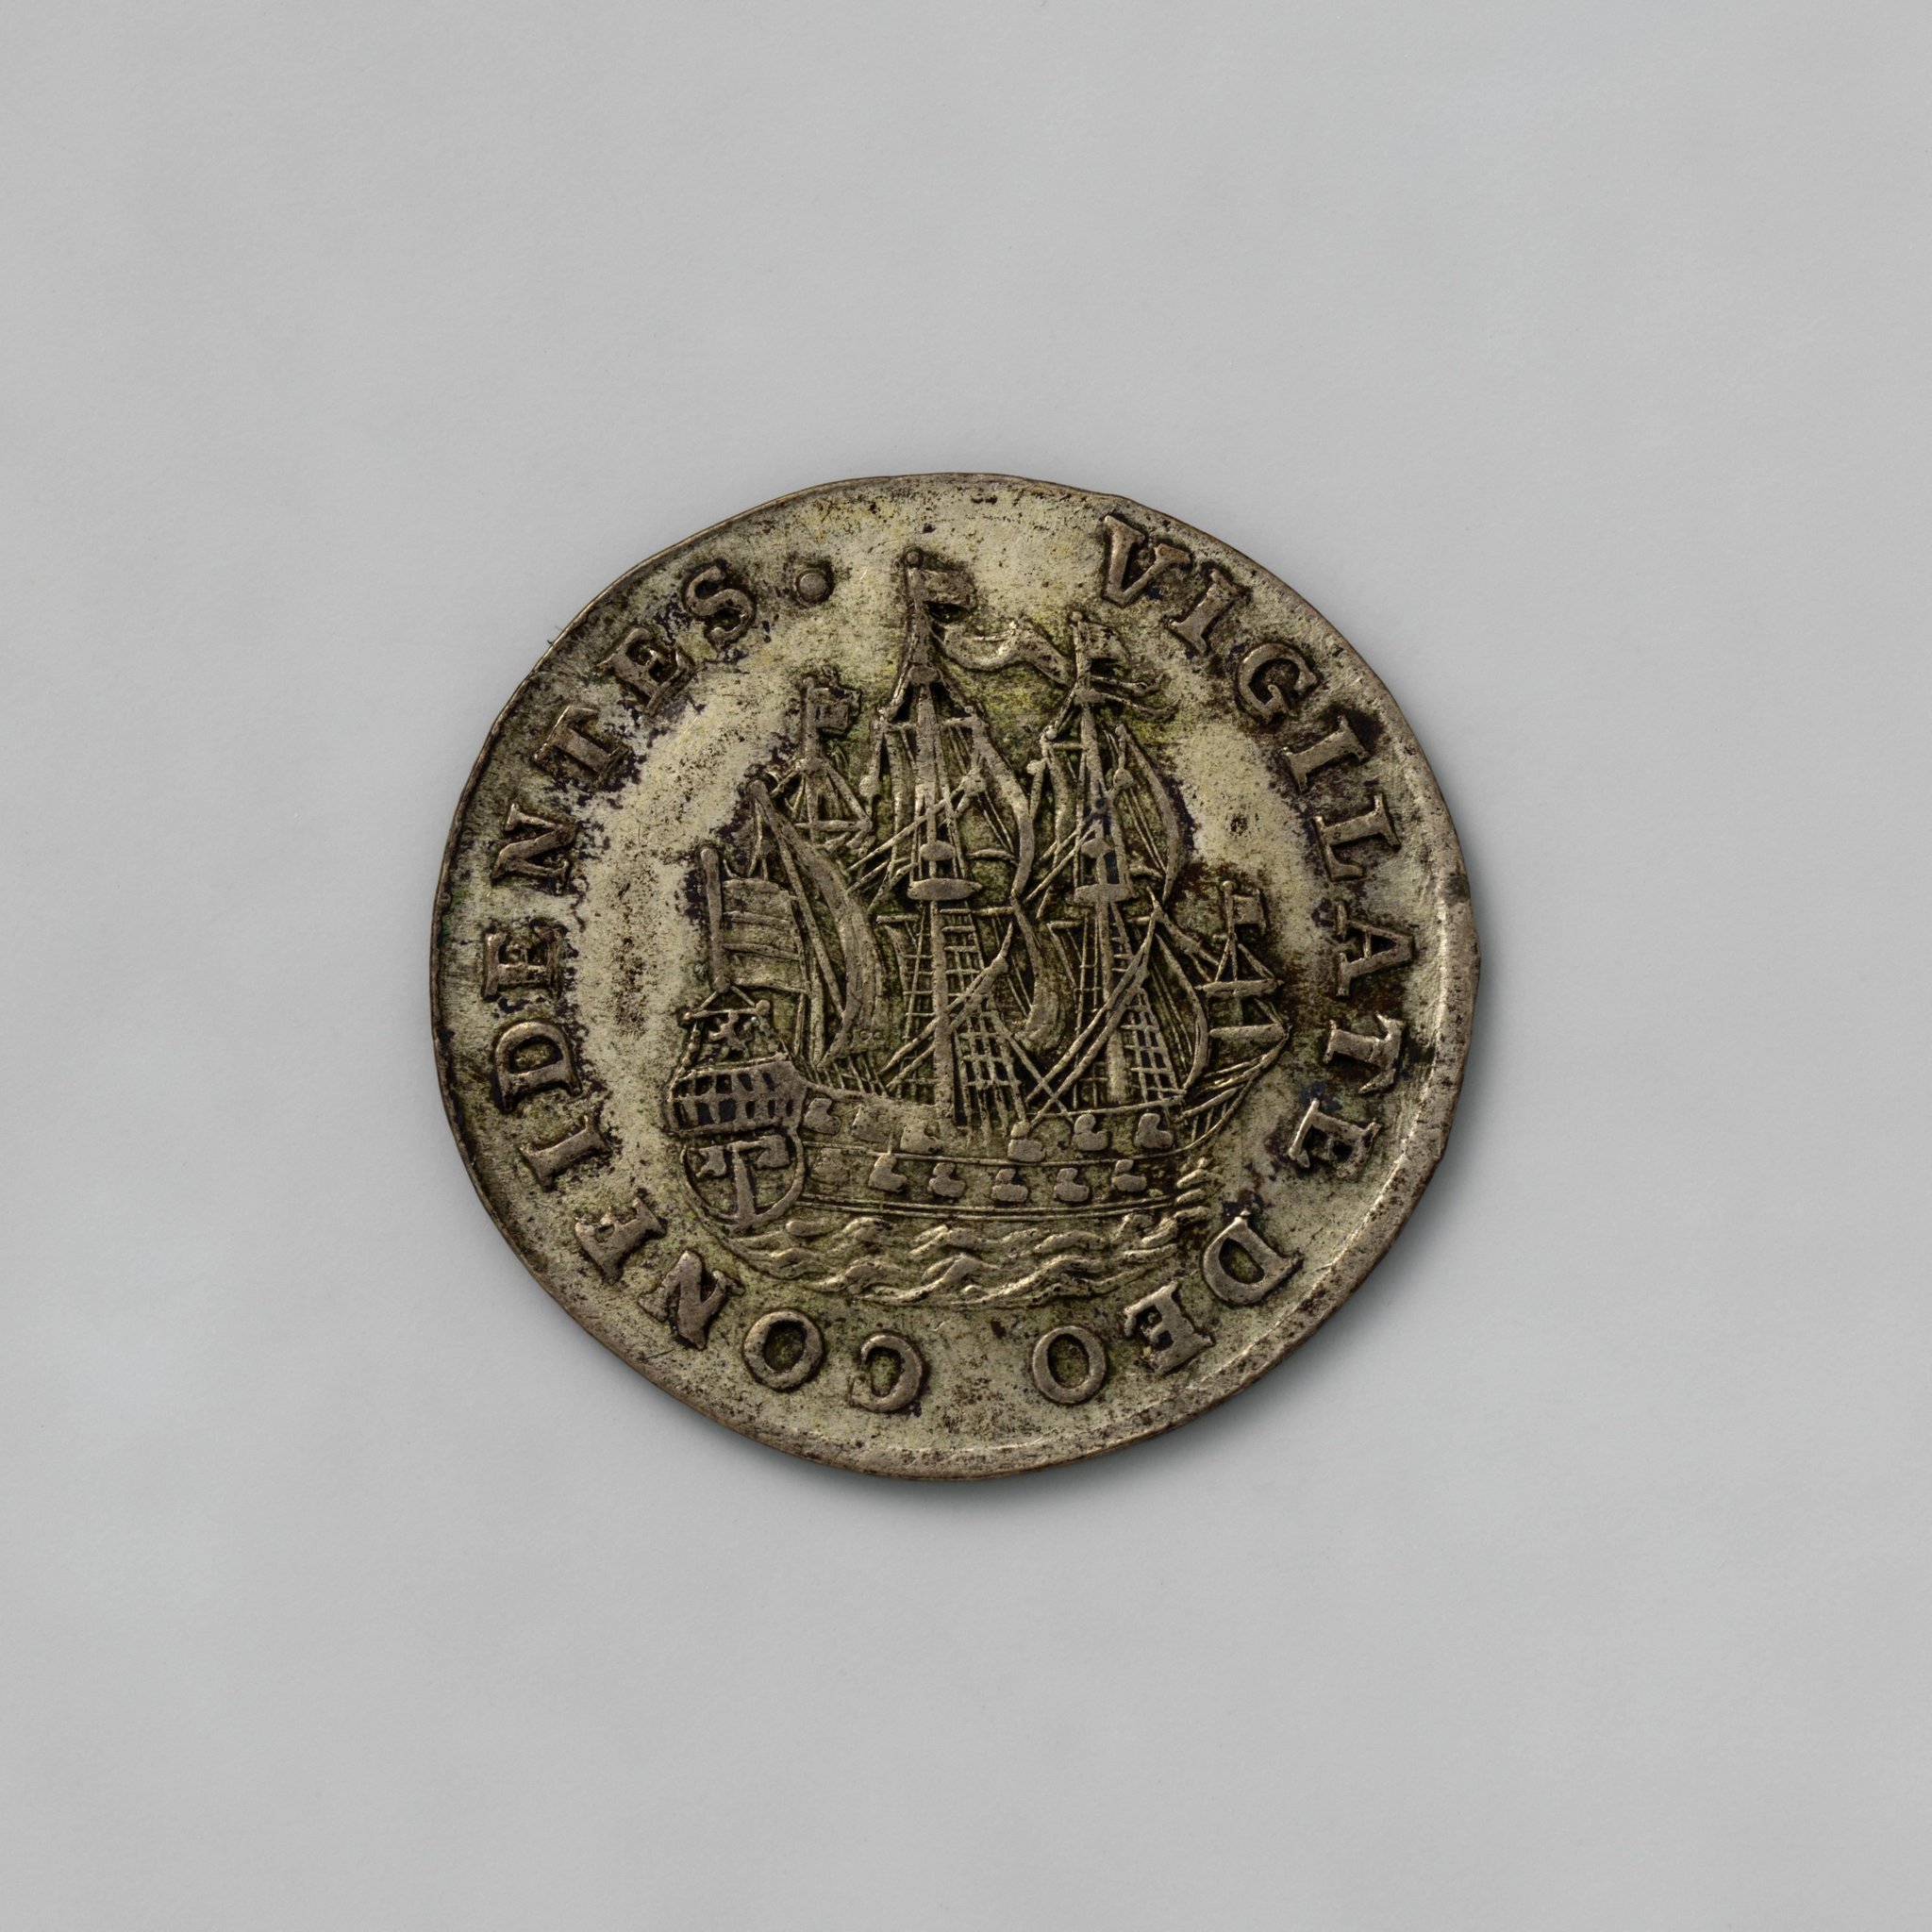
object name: coin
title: Holland, scheepjesschelling, 1736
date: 1736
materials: silver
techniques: striking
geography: dordrecht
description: Voorzijde: tussen waarde-aanduiding 6 S gekroond wapenschild van Holland. Jaartal boven kroon. Keerzijde: oorlogsschip, varend naar rechts.